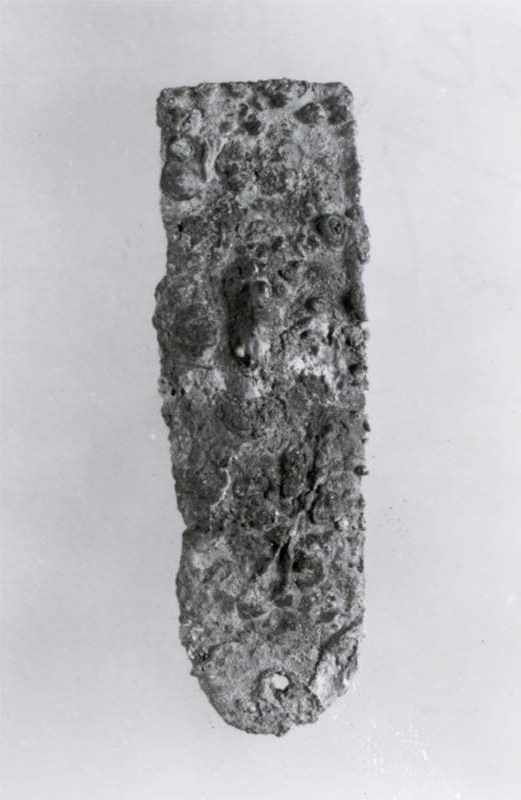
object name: armor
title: Armor plate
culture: assyrian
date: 734-601 BCE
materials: iron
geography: mesopotamia